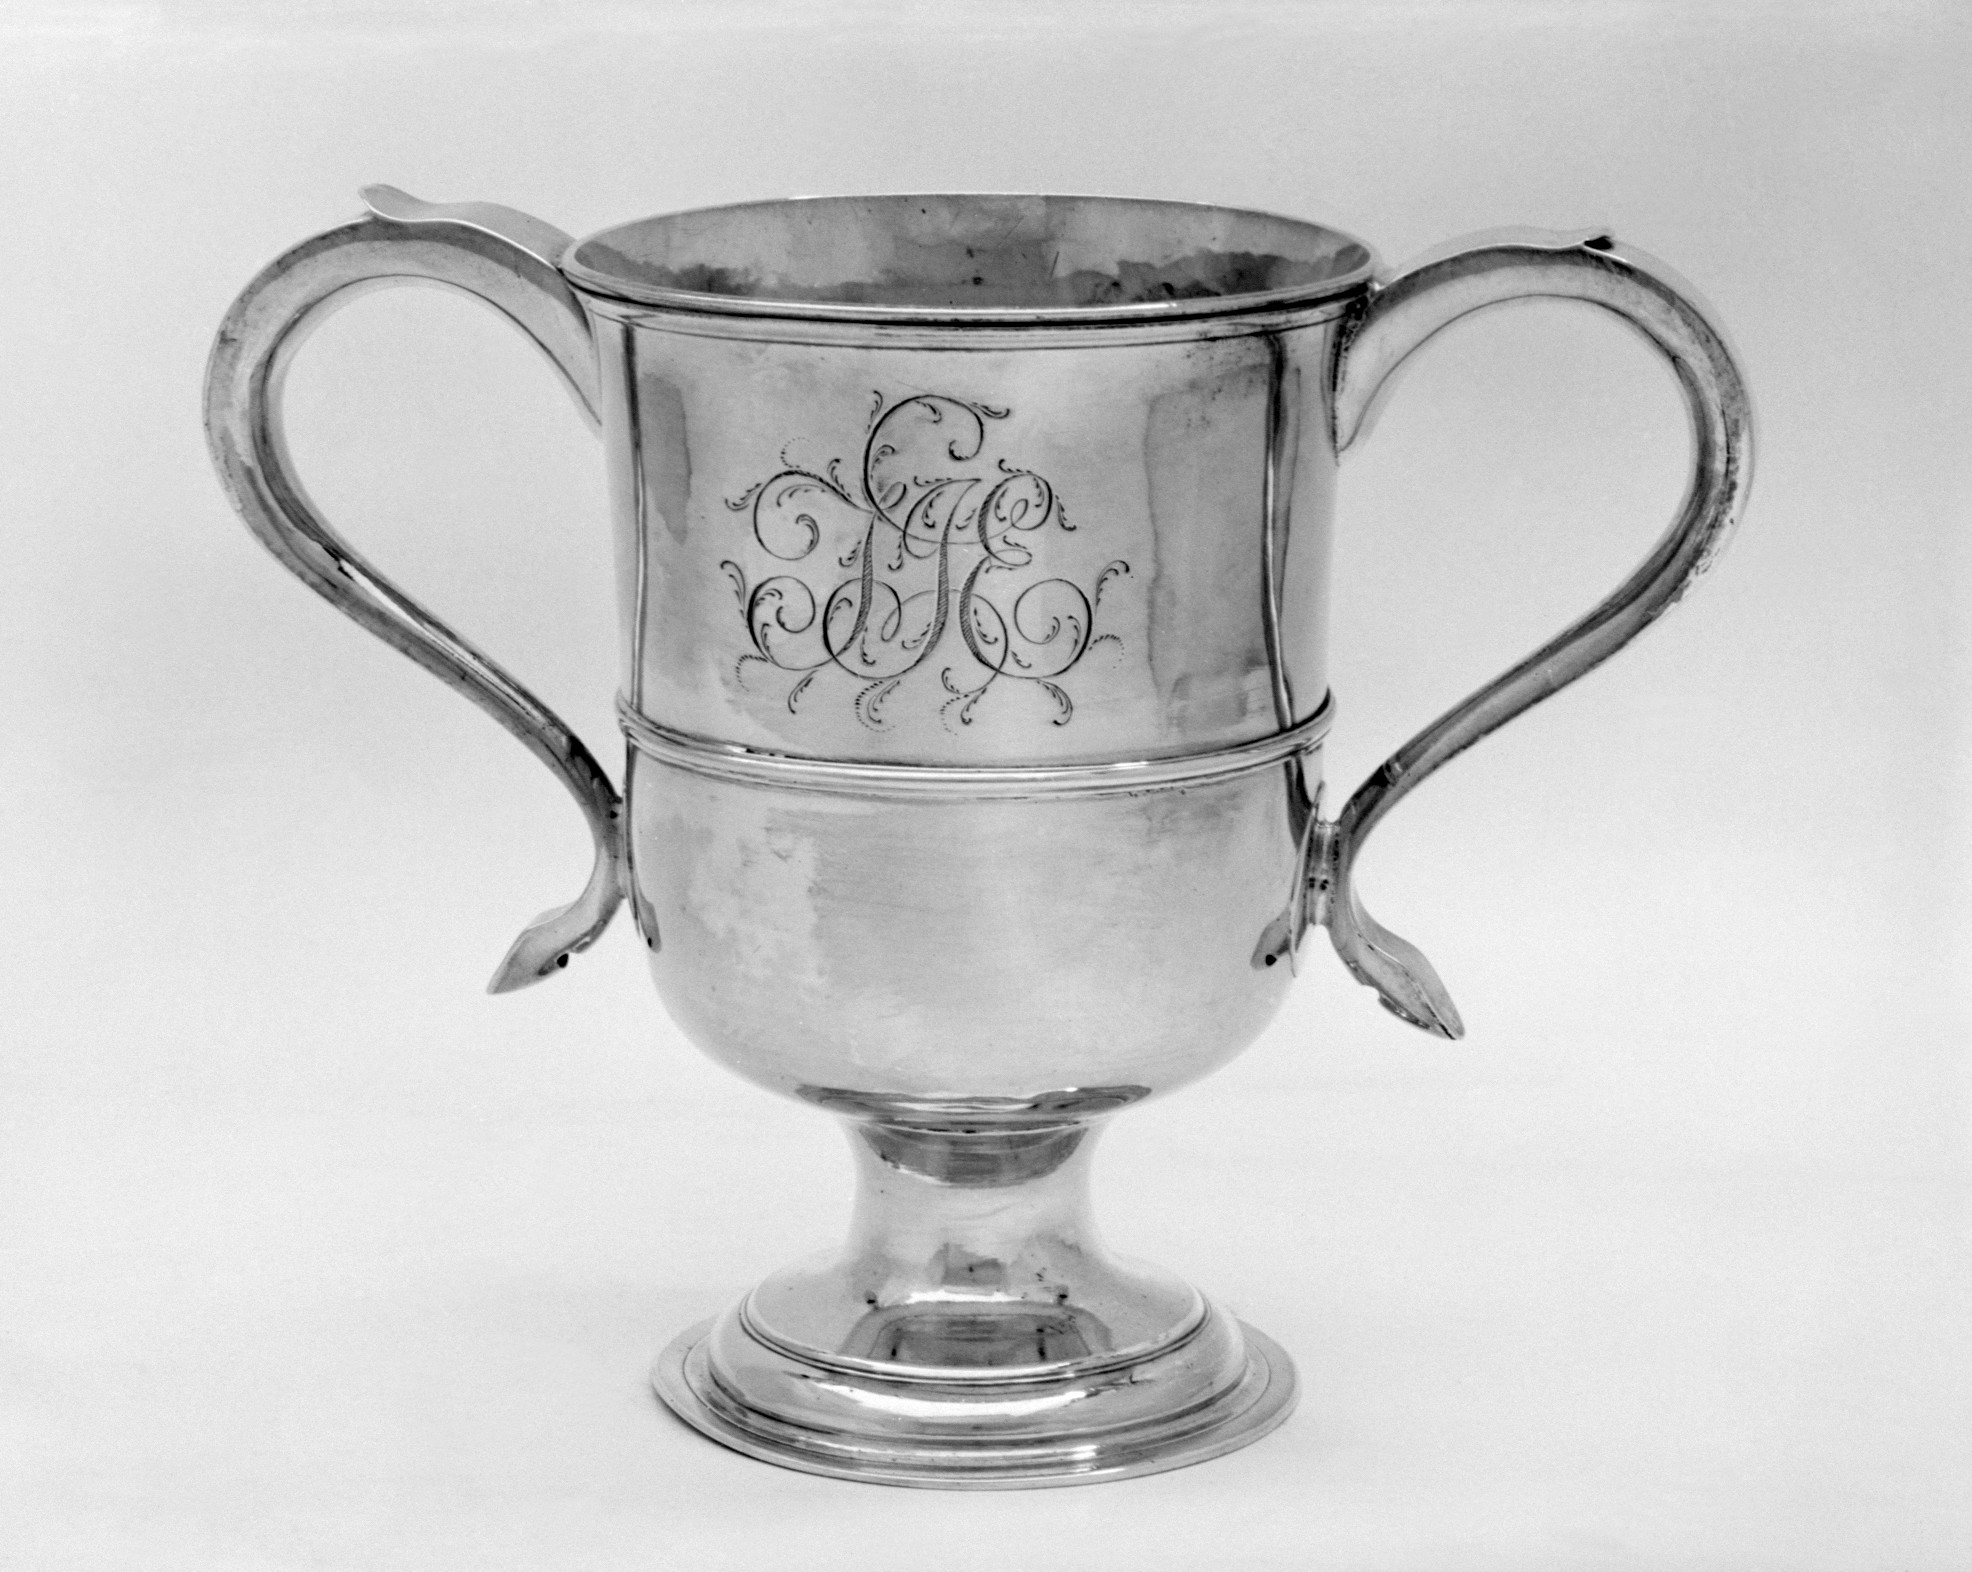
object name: cup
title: Two-handled cup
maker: john langlands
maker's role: maker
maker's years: 1725-1825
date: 1791-1792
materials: silver